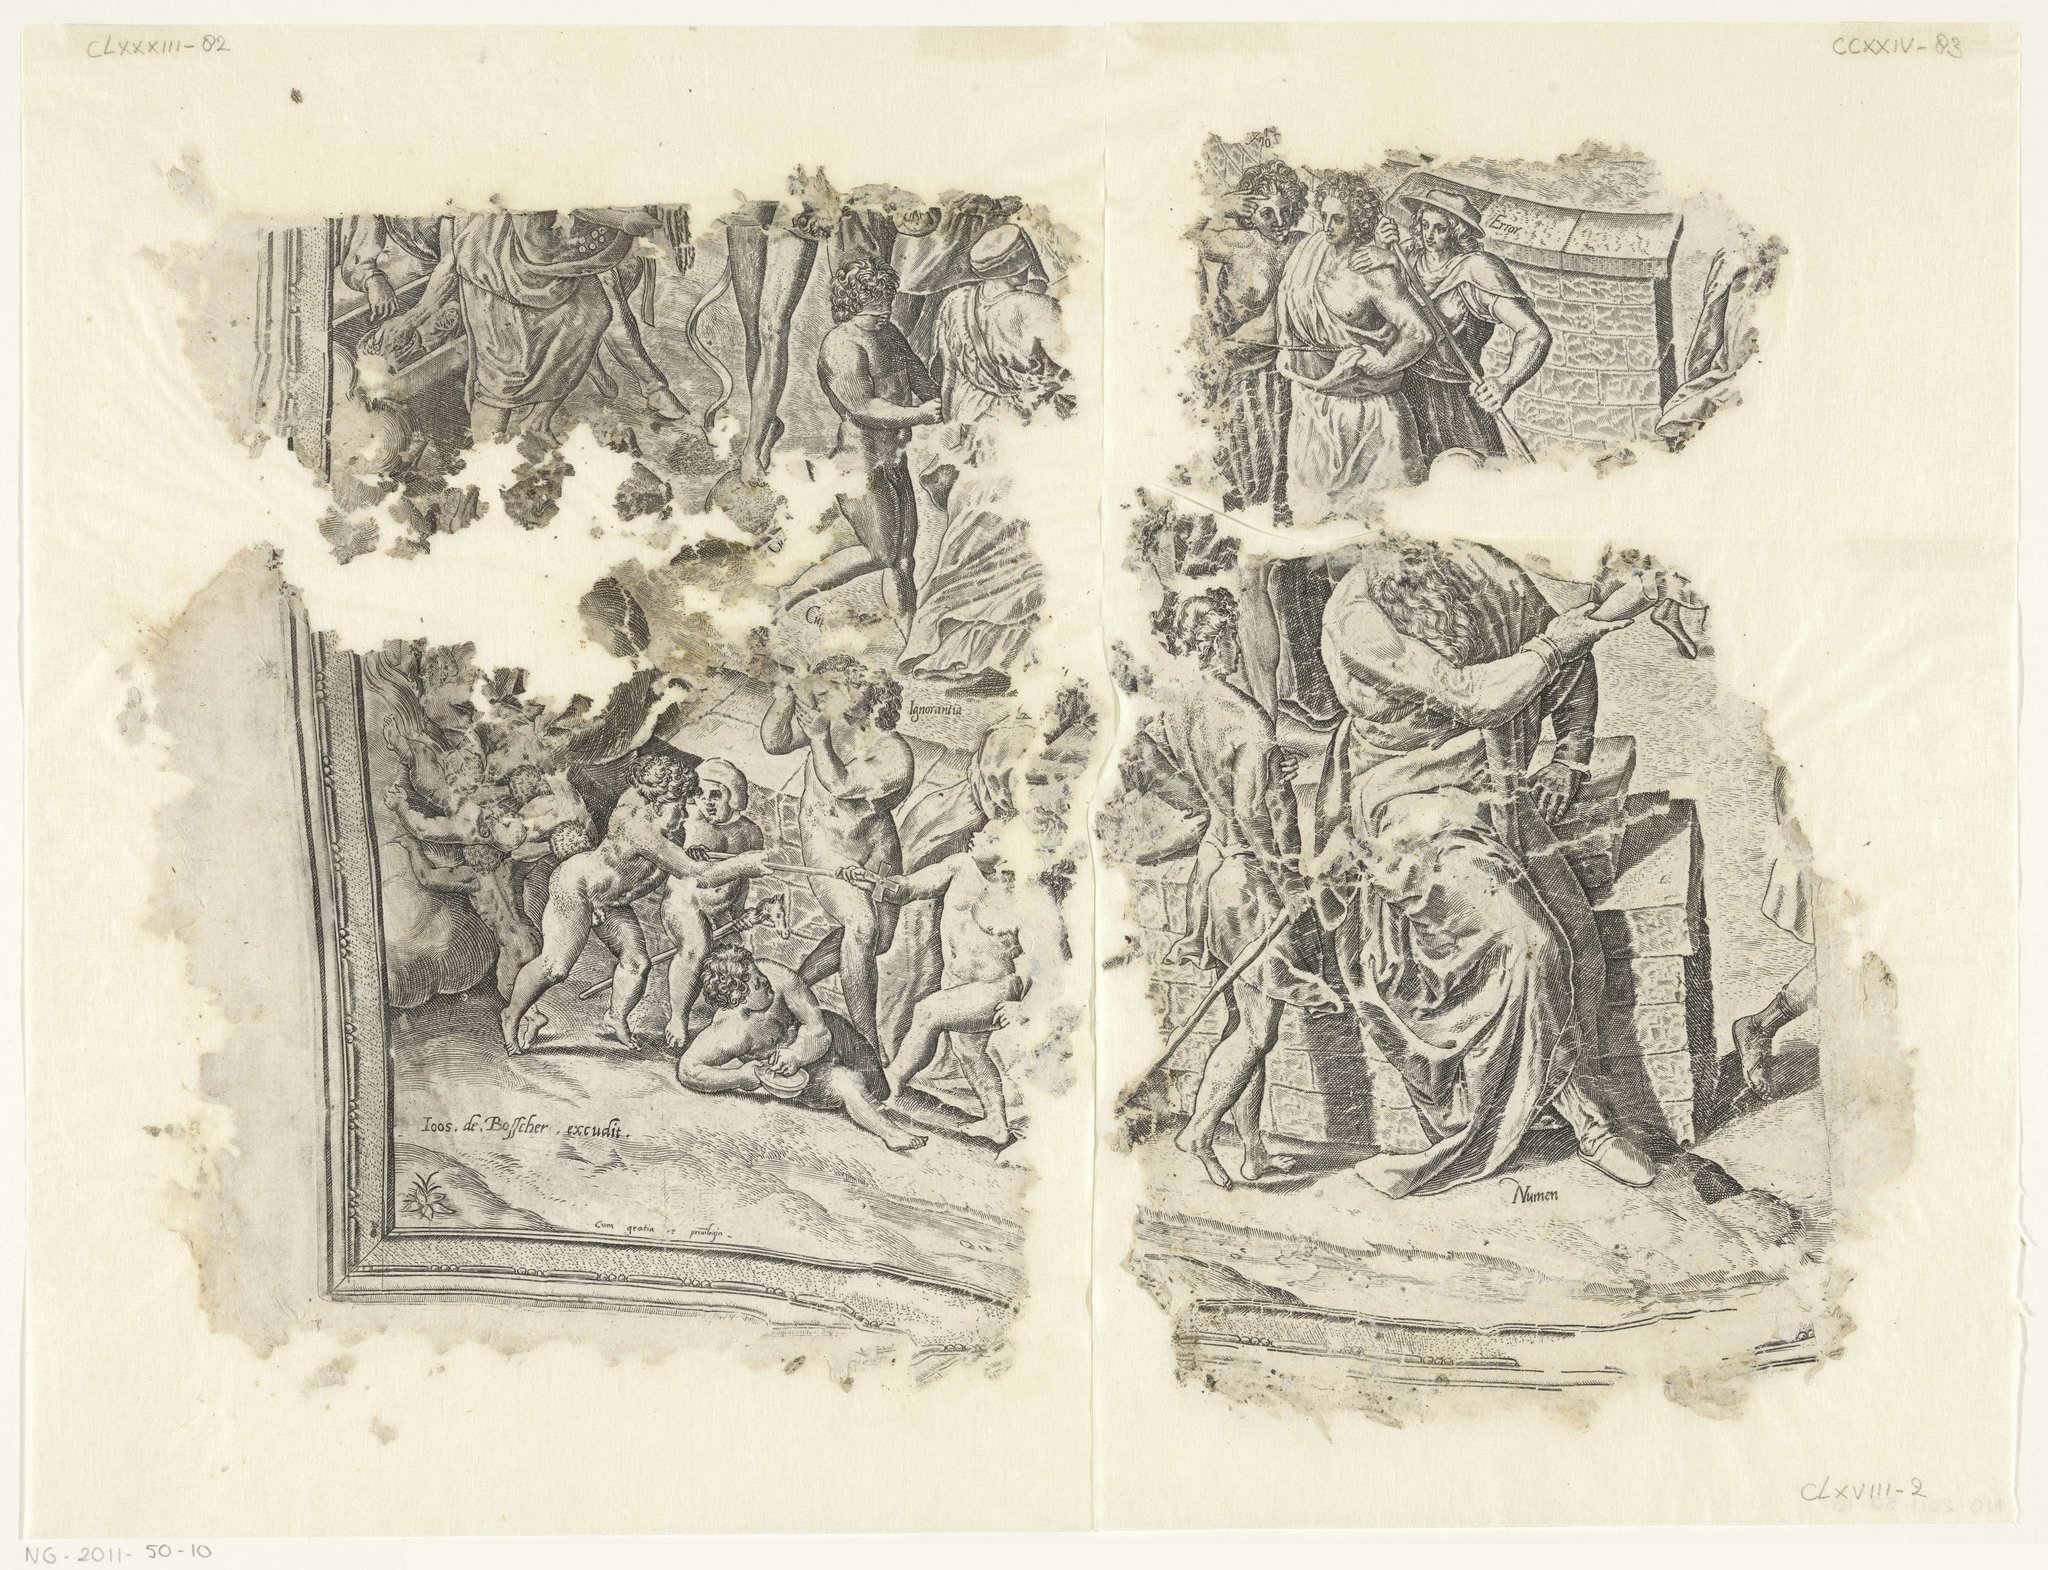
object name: print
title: Linkeronderhoek van een prent van het tafereel van Cebes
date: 1561-1596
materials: paper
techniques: engraving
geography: southern netherlands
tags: 'tabula cebetis'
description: Allegorie over de heilsweg van de mens. Het leven als een stad met drie ommuurde terreinen, met in het midden een tempel. Bij de buitenste poort staan de zielen van kinderen te wachten, klaar om het volwassen leven te betreden. Voor het binnengaan krijgen zij iets te drinken van Verleiding (Seductio), die hen onwetend maakt. Het eerste ommuurde terrein toont allerlei ver- en afleidingen, zoals Vooroordeel (Opinio), Begeerte (Cupiduas), Twijfel (Error) en Onwetendheid (Ignorantia). Zij beletten de jeugdige mens verder door te dringen tot de volgende cirkel. Alleen door de personificaties te volgen van Berouw (Poenitentia), Hoop (Spes) en Goed Verlangen (Bonnem Desiderium) kan de mens toegang krijgen tot de tweede cirkel. Daar krijgt hij onderricht in alle vormen van wereldse kennis. Links staan de zeven artes liberales en rechts debatteren verschillende geleerden. De mens wordt in deze cirkel op de proef gesteld en geconfronteerd met valse kennis (Falsa Disciplina). Met behulp van Zelfbeheersing (Continentia) en Geduldigheid (Tolerantia) kan de berg verder worden beklommen. Het derde ommuurde terrein, ten slotte, wordt bewaakt door Waarheid (Veritas). Zij verleent de mens toegang tot het ware geluk. Hij wordt er verwelkomd door de kardinale deugden en mag verblijven in het huis van de gelukzaligen, waar het ware geluk op hem wacht. Gereconstrueerd uit drie fragmenten.